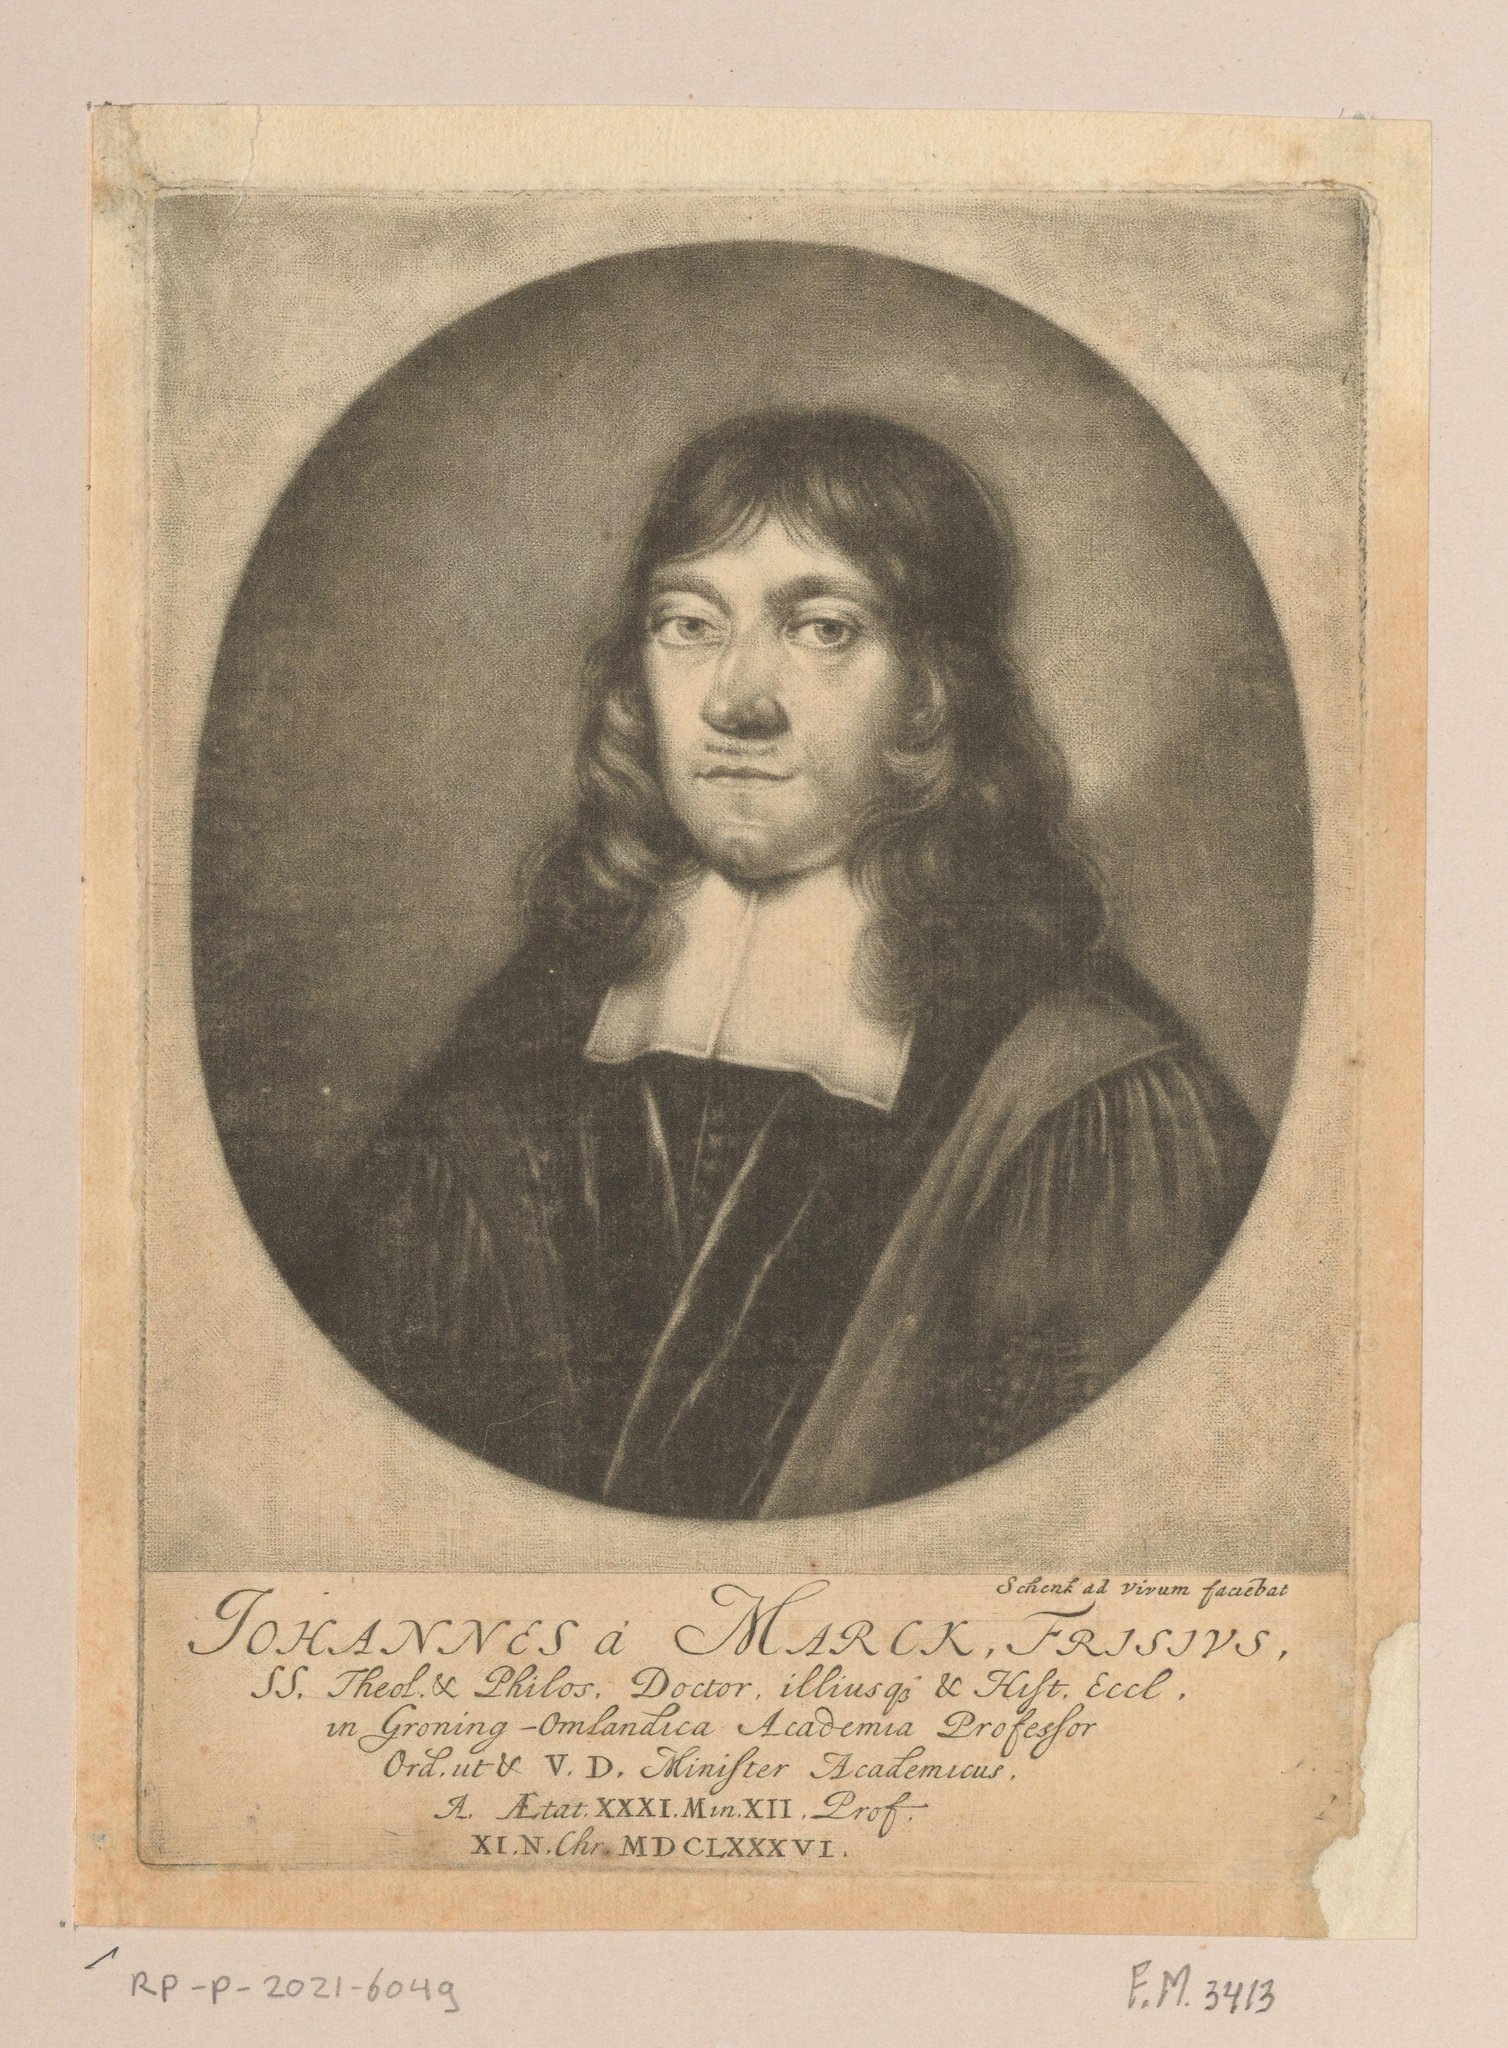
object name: print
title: Portret van Johannes à Marck op 31-jarige leeftijd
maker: pieter schenk (i)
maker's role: print maker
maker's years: 1660-1711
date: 1686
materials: paper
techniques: mezzotint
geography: amsterdam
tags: theologian, historical persons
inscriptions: date